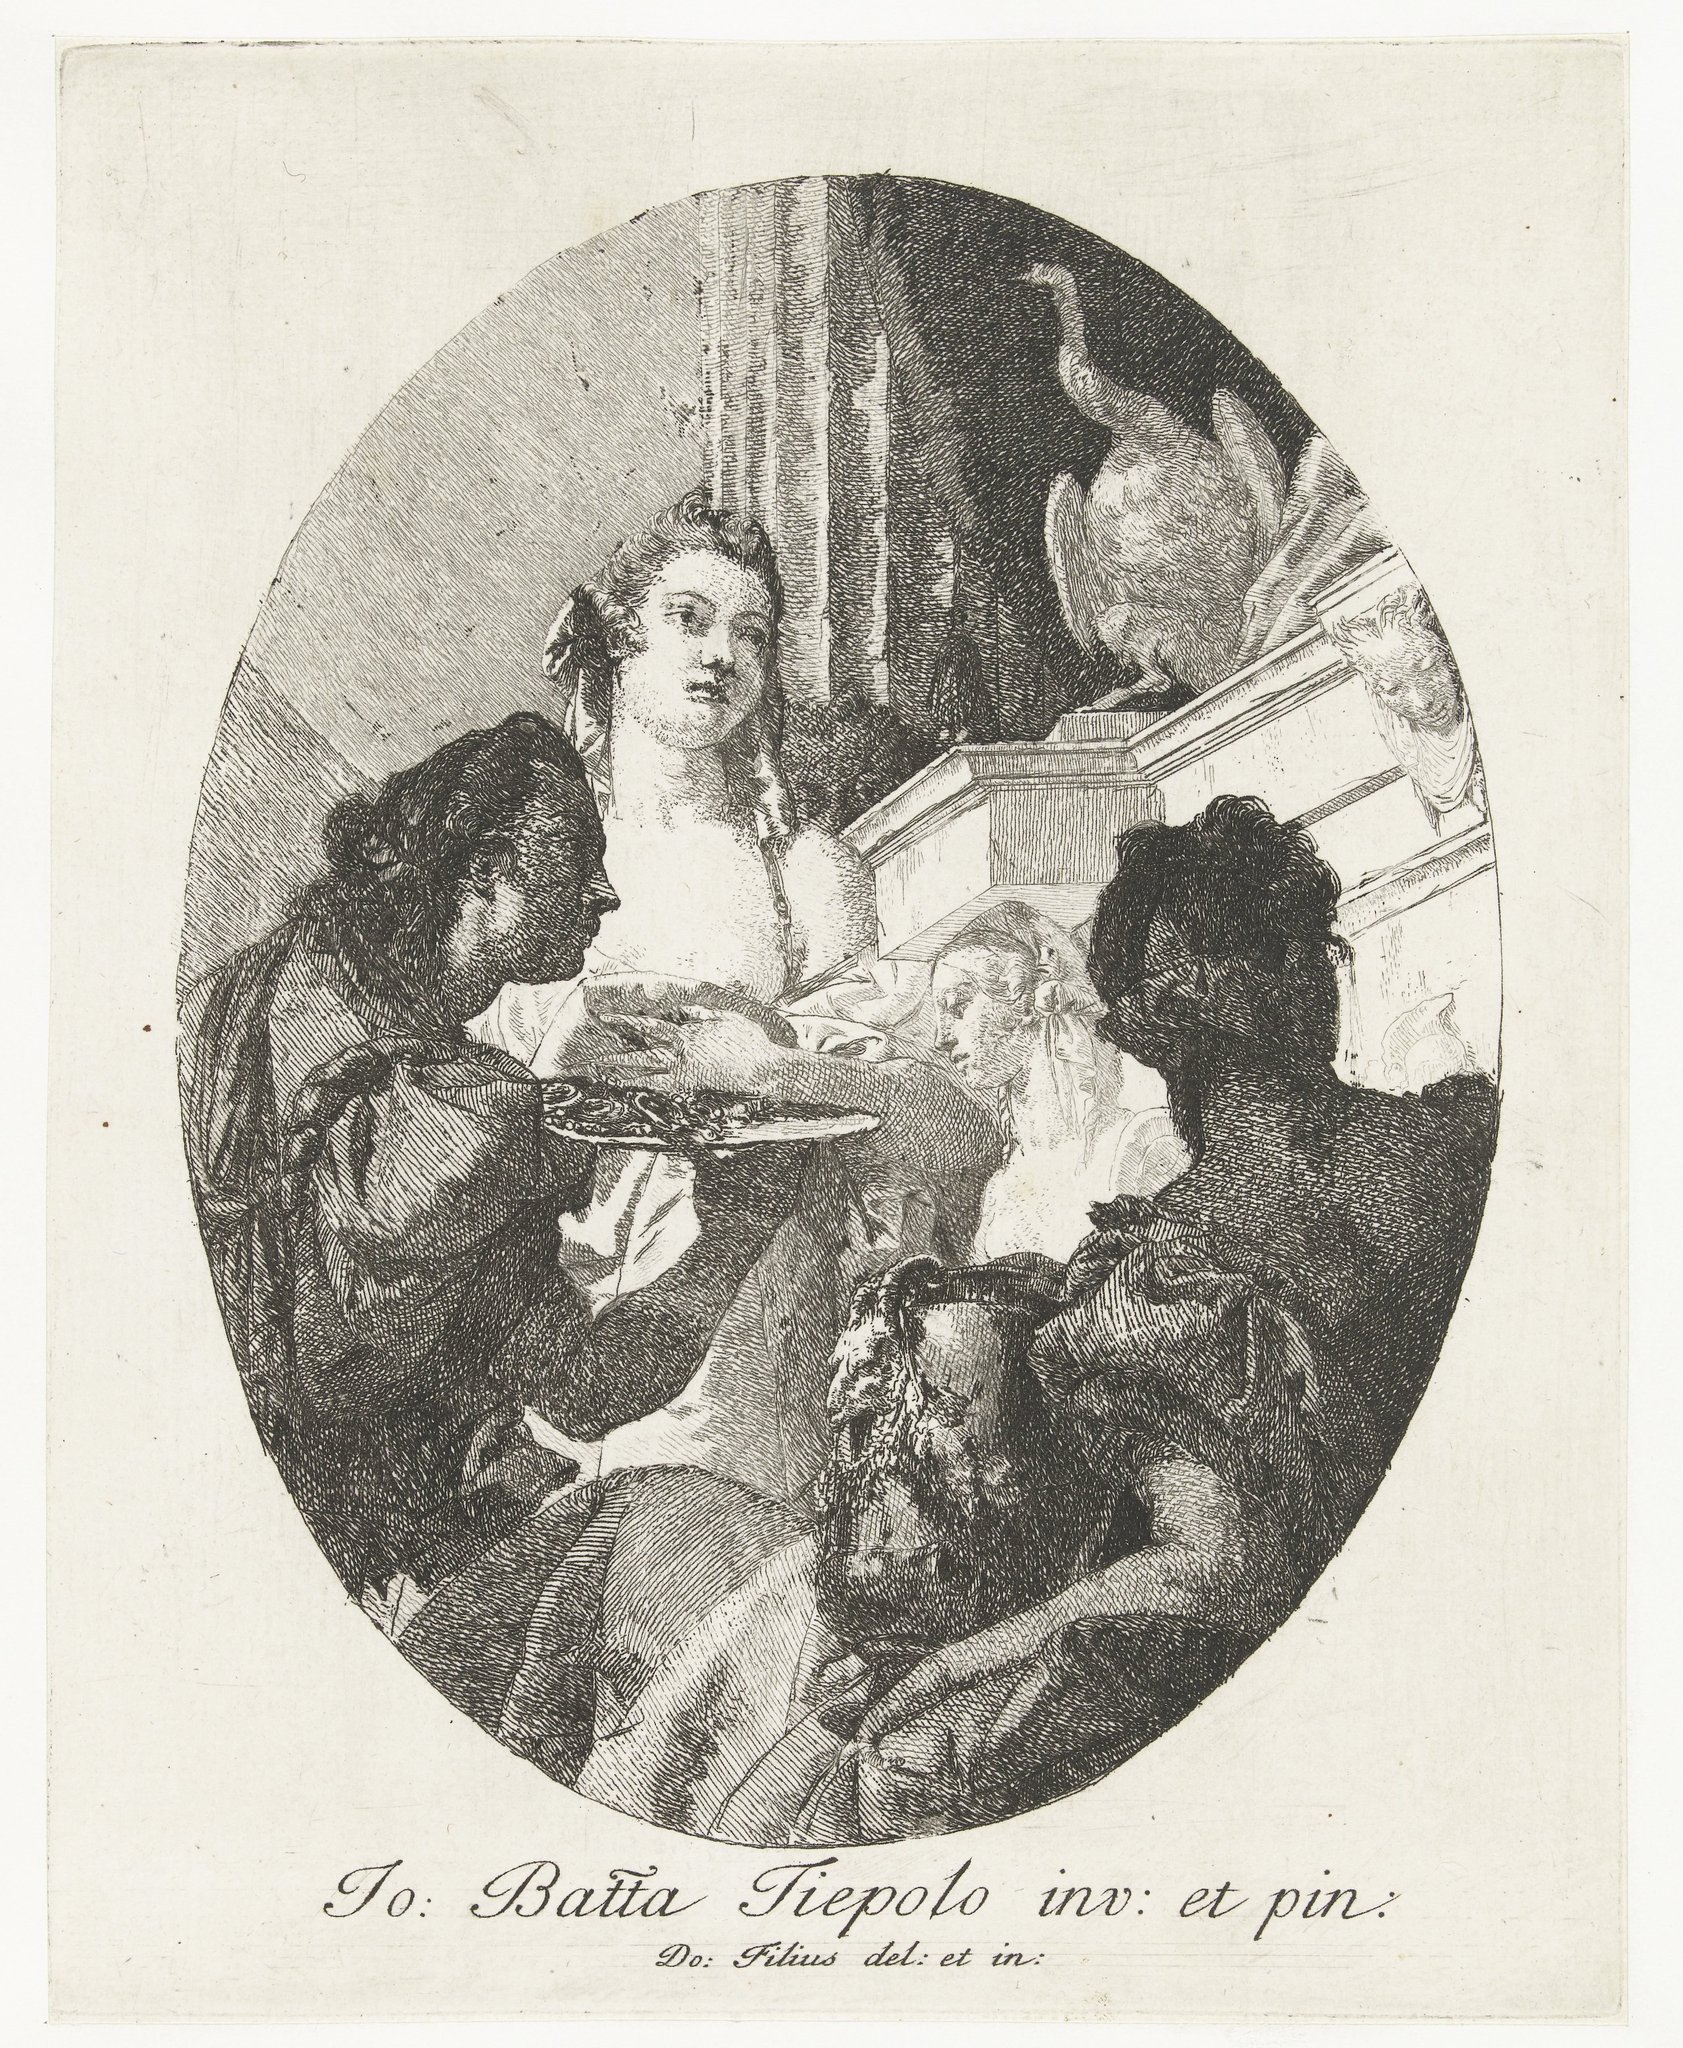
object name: print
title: Cleopatra en bedienden met sieraden en vat wijn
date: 1743-1747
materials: paper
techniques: etching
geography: venice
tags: banquet of mark antony and cleopatra: she dissolves a pearl in a cup of wine, which she then drinks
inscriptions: collector's mark: Lugt 2228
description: Prent naar ontwerp van Giovanni Battista Tiepolo.